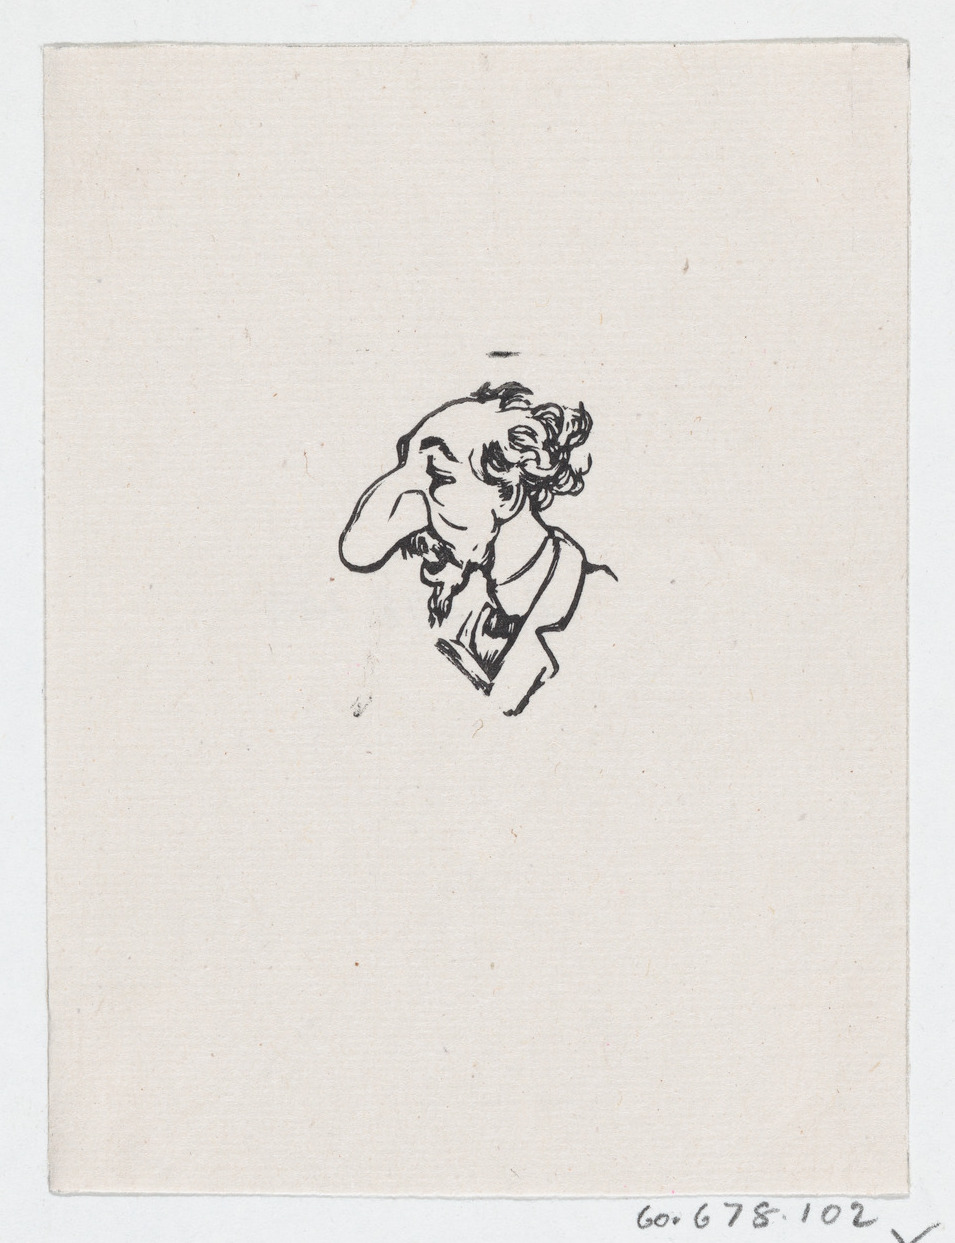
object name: print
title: A profile of a man with a large nose looking to the left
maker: josé guadalupe posada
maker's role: artist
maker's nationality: mexican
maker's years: 1852-1913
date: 1880-1910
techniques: lithography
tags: men,profiles